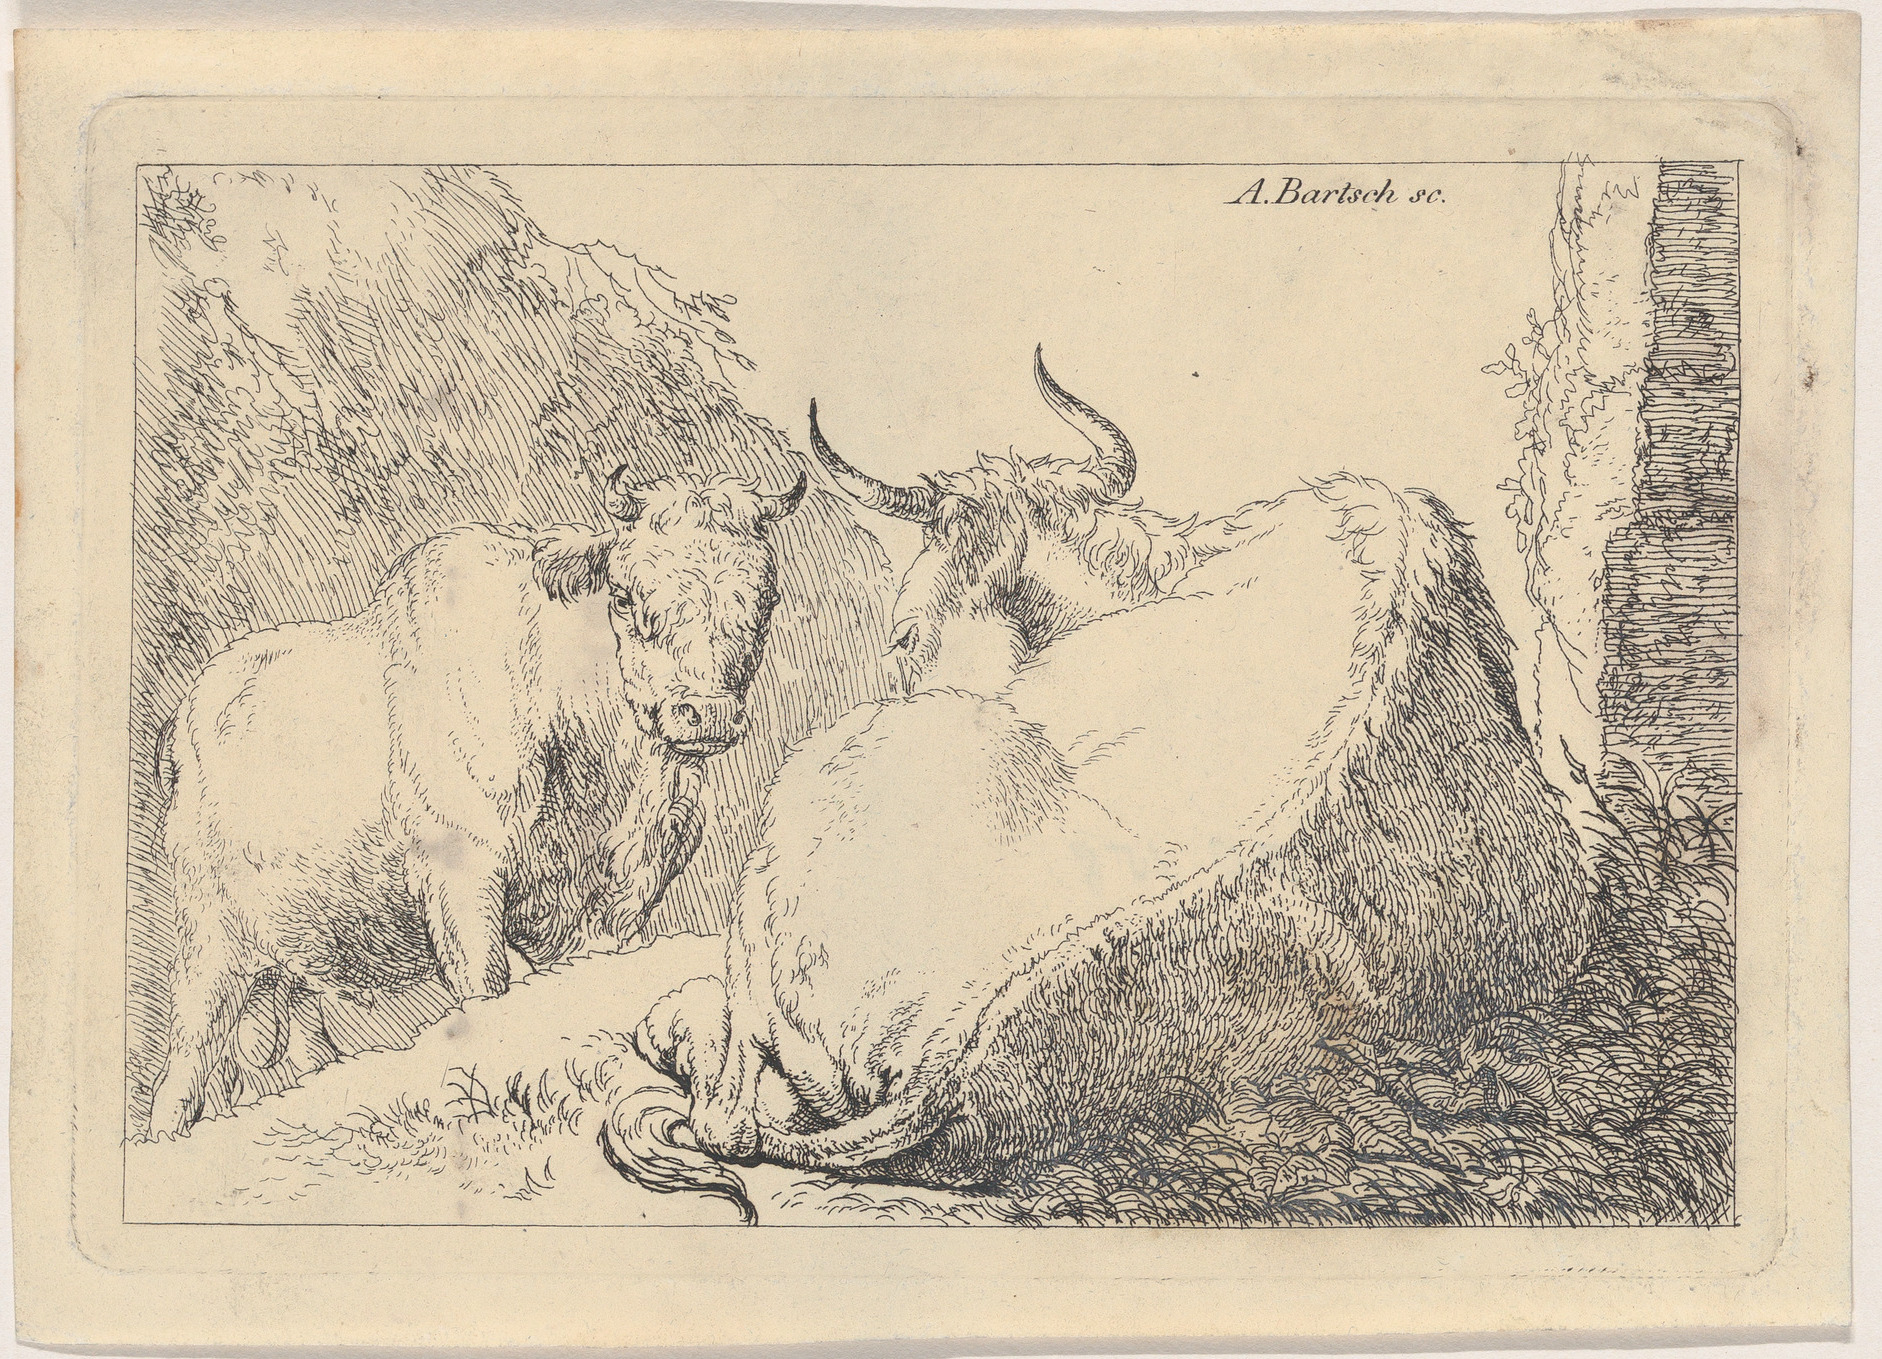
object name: print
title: A reclining cow, seen from behind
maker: adam von bartsch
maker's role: etcher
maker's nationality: austrian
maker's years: 1757-1821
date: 1803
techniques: etching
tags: cows